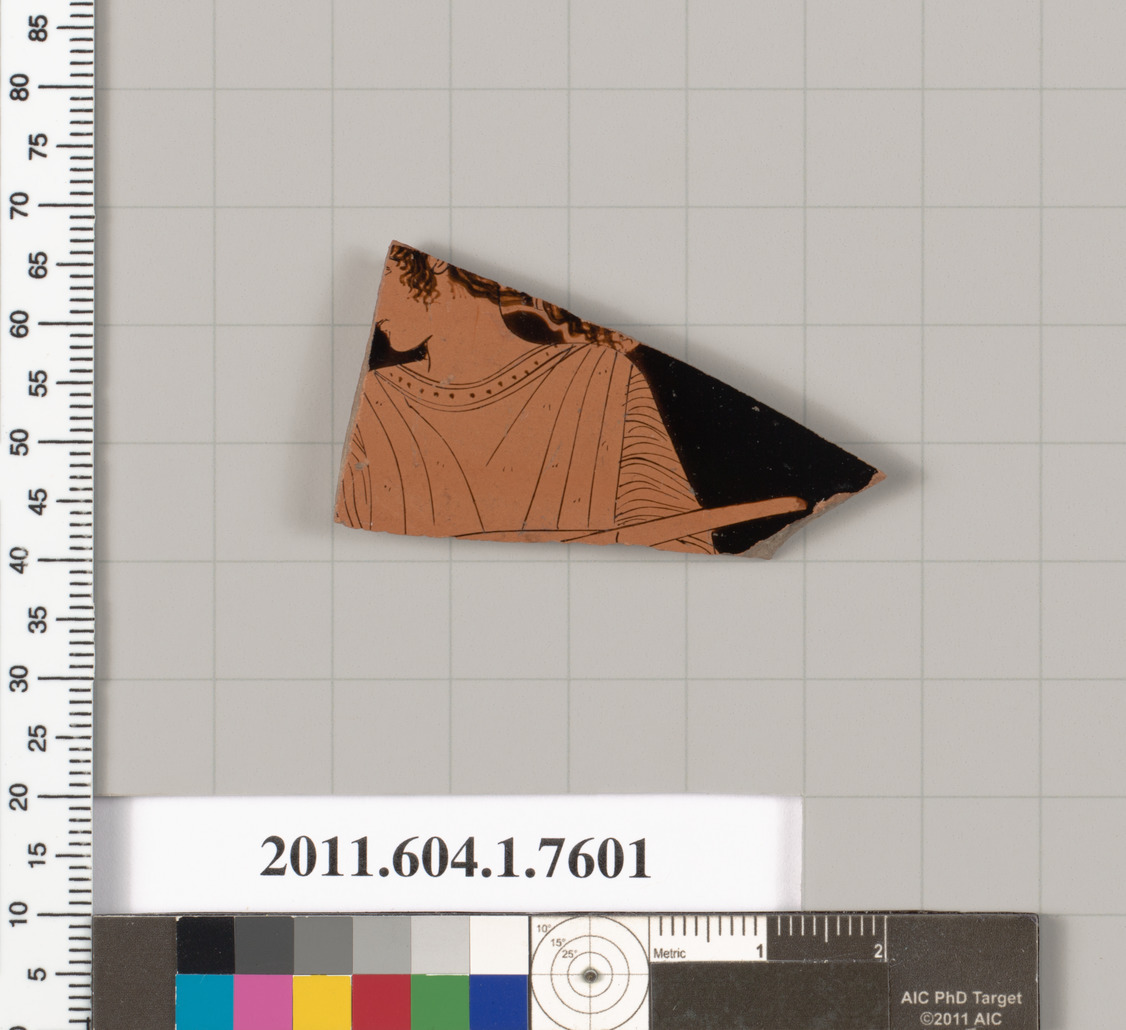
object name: kylix fragment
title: Terracotta fragment of a kylix (drinking cup)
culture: greek, attic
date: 460-450 BCE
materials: terracotta